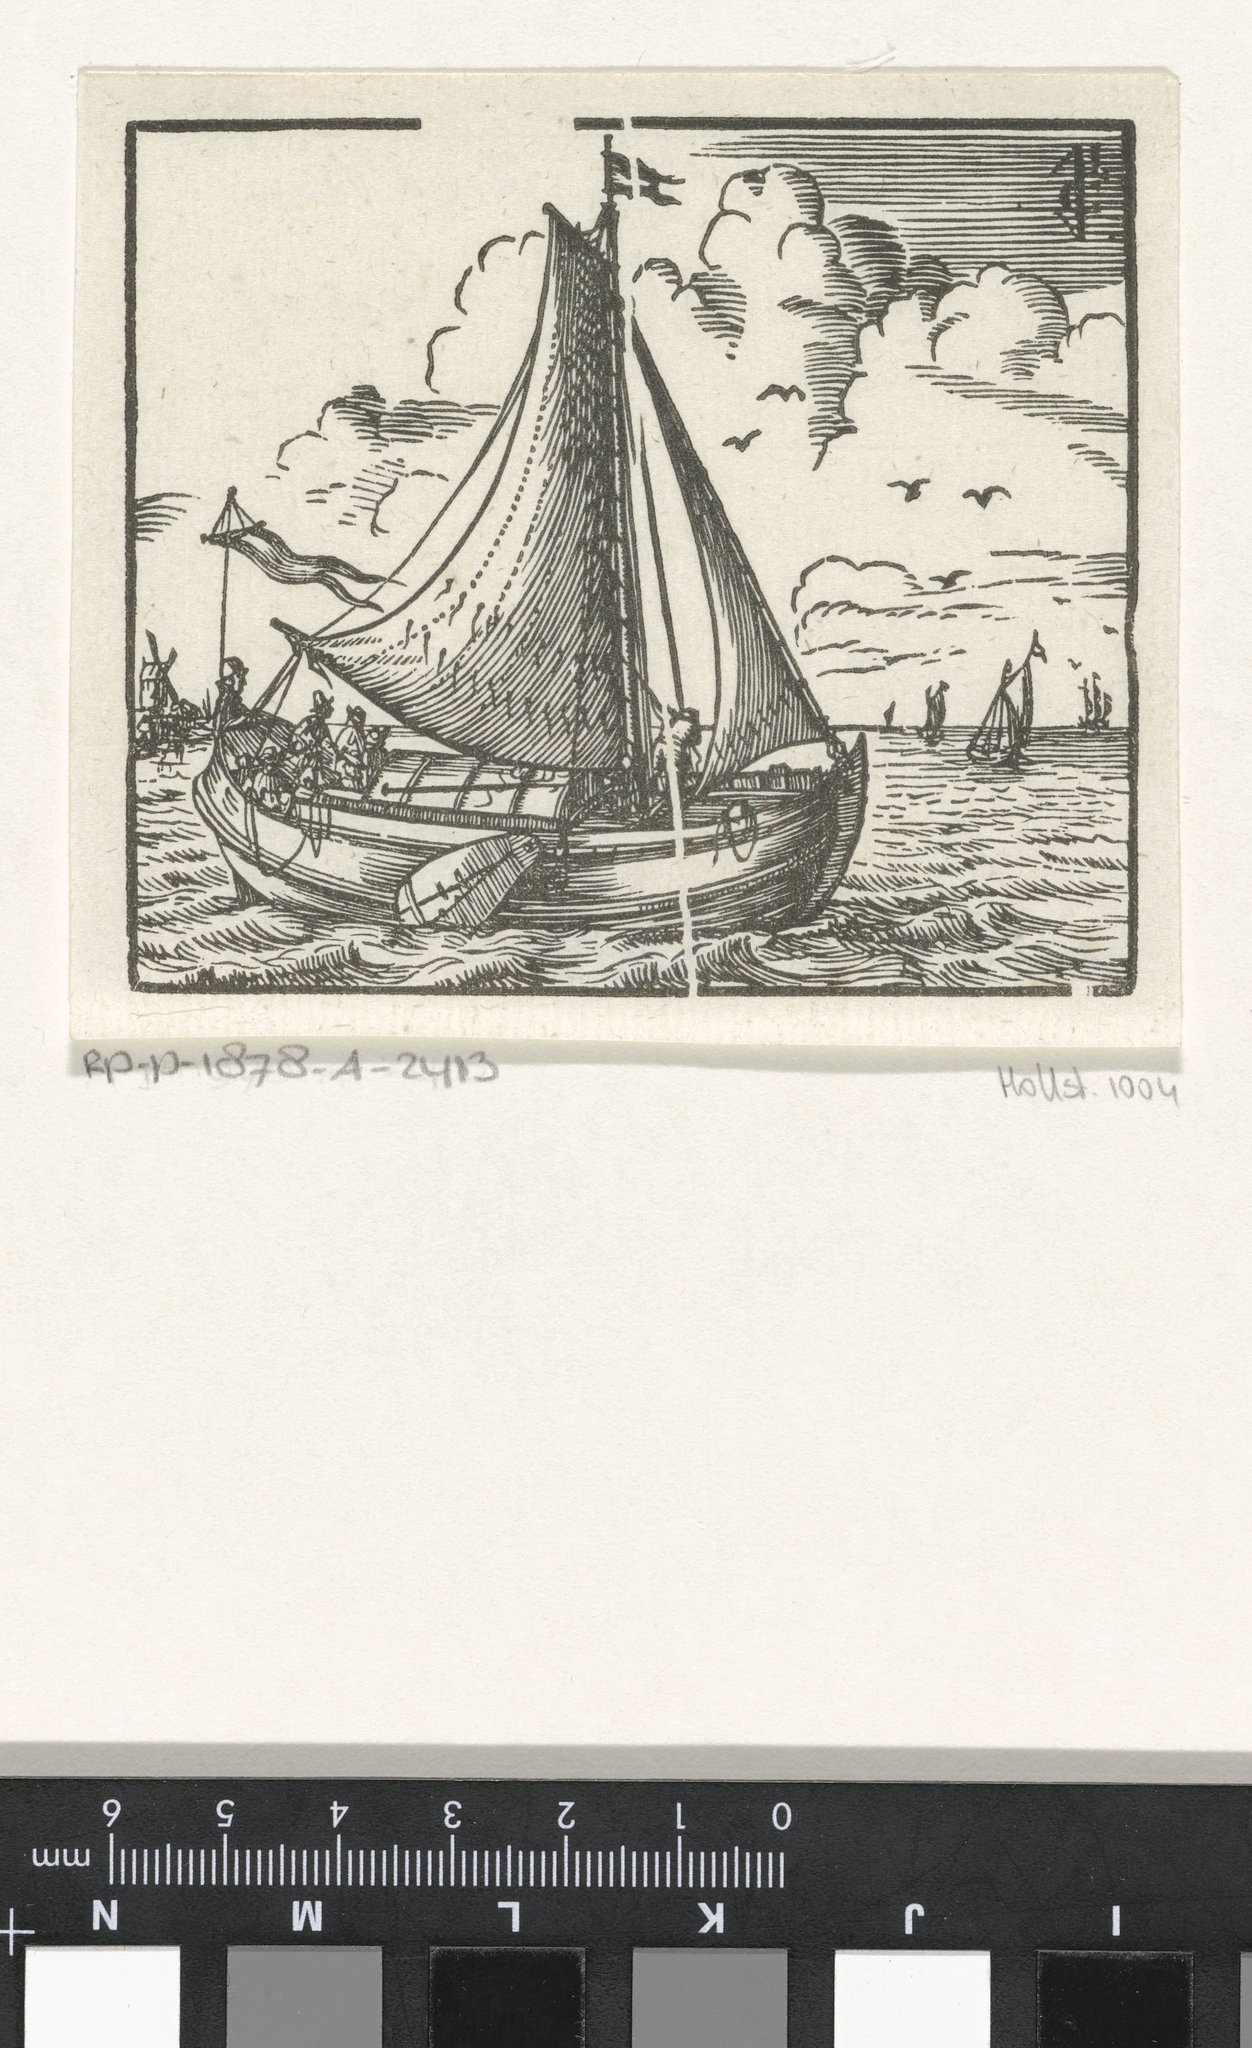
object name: print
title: Zeilschip nabij een kust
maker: isaac vincentsz. van der vinne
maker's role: draughtsman, print maker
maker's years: 1665-1740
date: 1681-1740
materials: paper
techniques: woodcut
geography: haarlem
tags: sailing-ship, sailing-boat, coast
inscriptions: collector's mark: Lugt 2228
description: Rechtsboven het monogram van de uitgever Abraham Casteleyn.